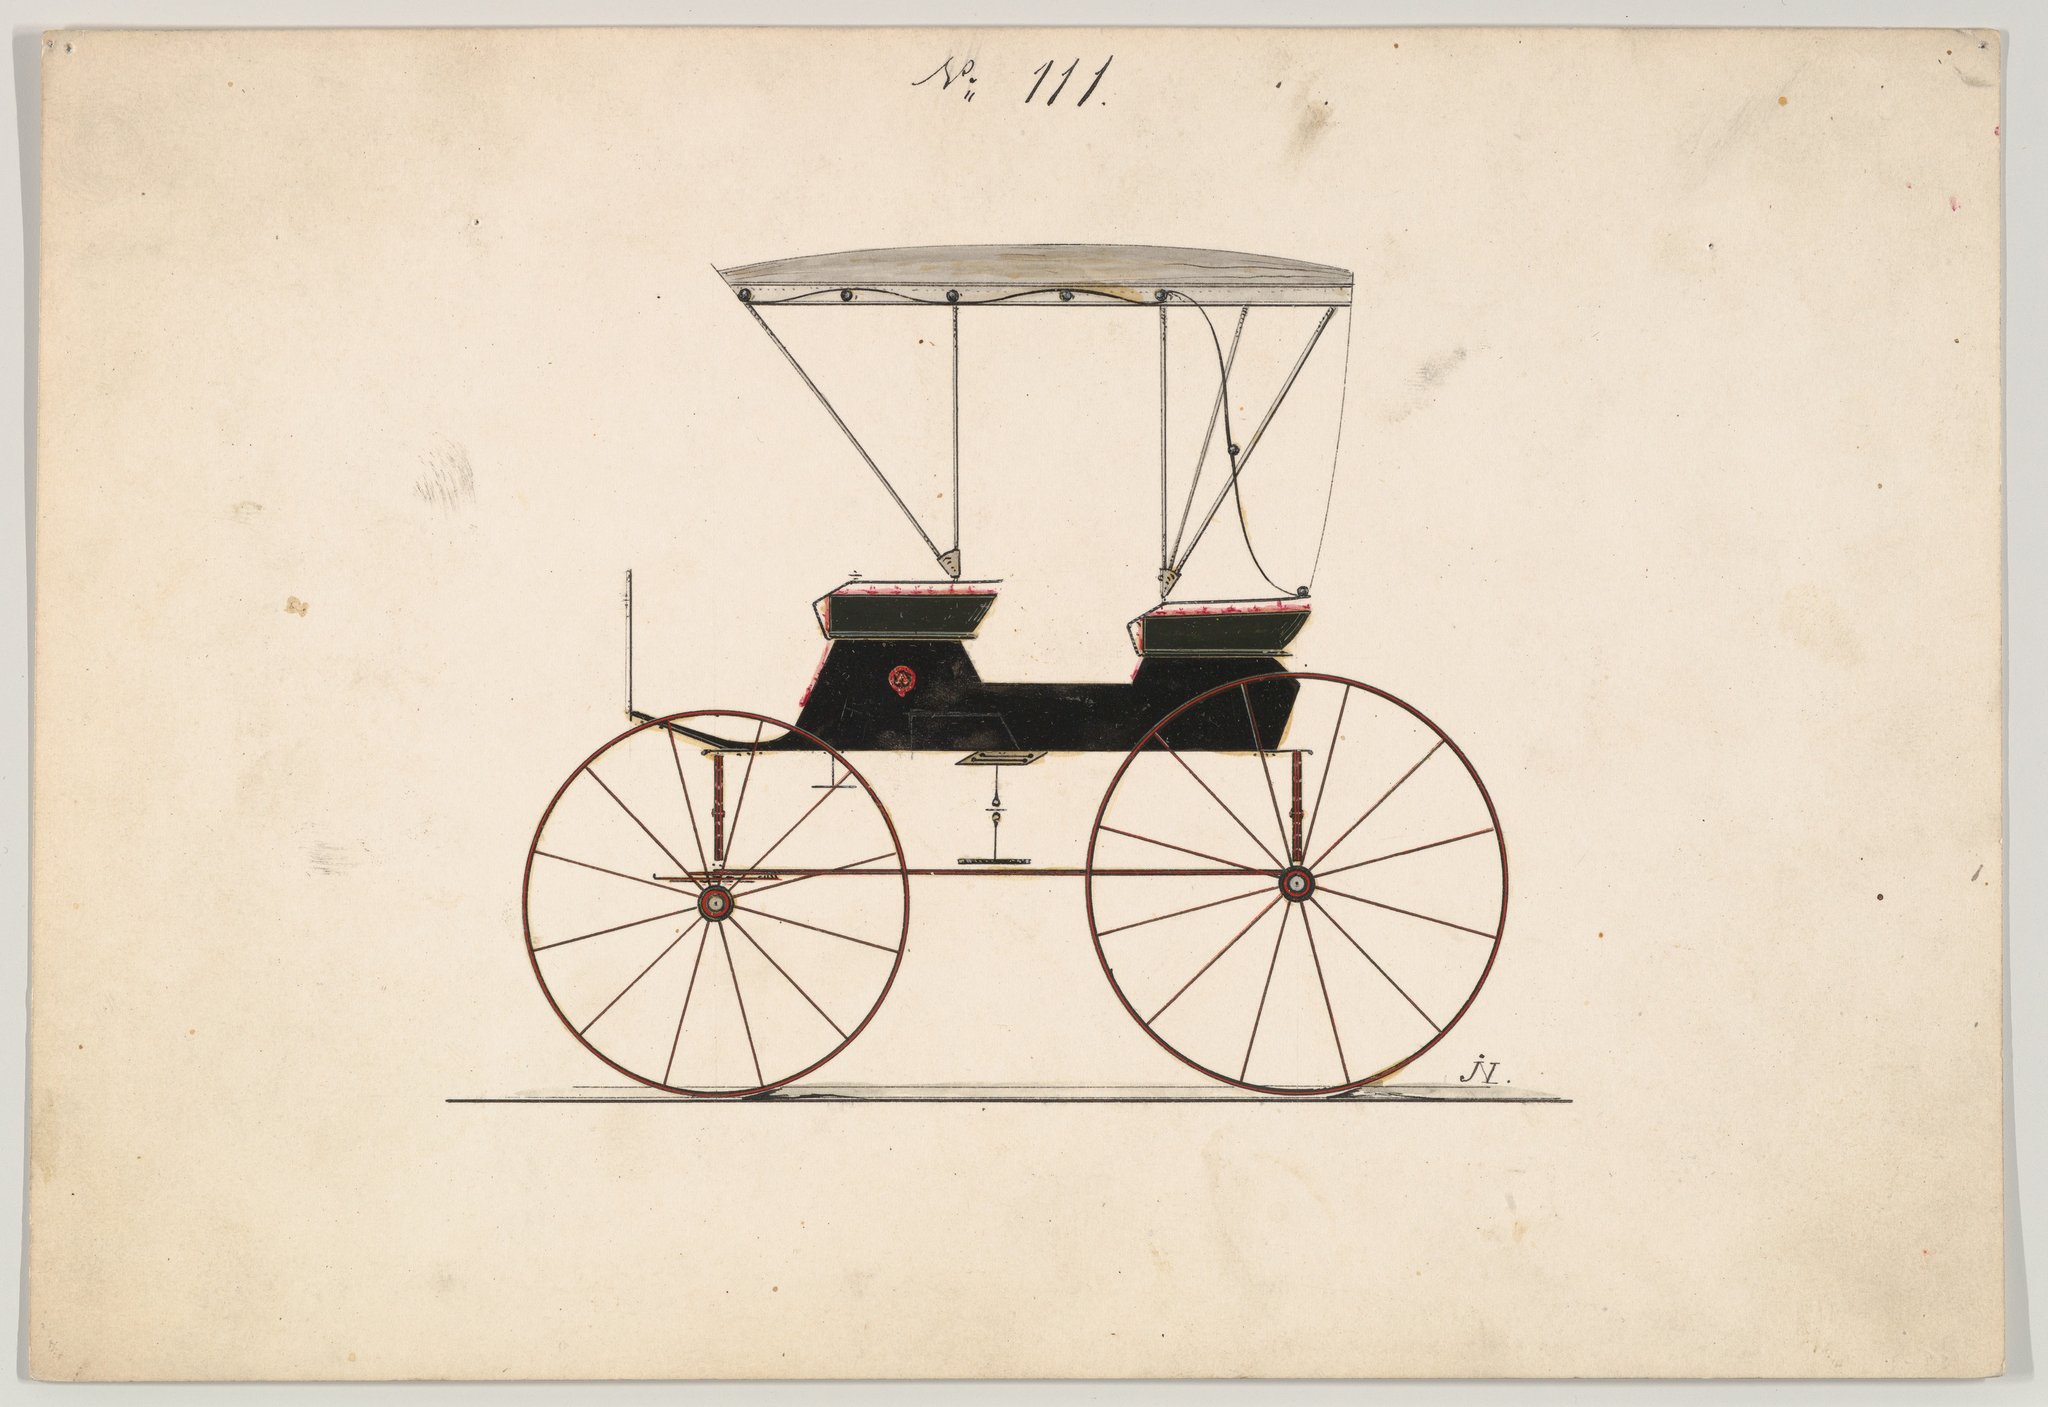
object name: drawing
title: Extension Top Phaeton #111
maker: brewster & co.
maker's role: manufacturer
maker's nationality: american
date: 1865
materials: gouache, gum arabic, ink, watercolor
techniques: pen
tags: carriages